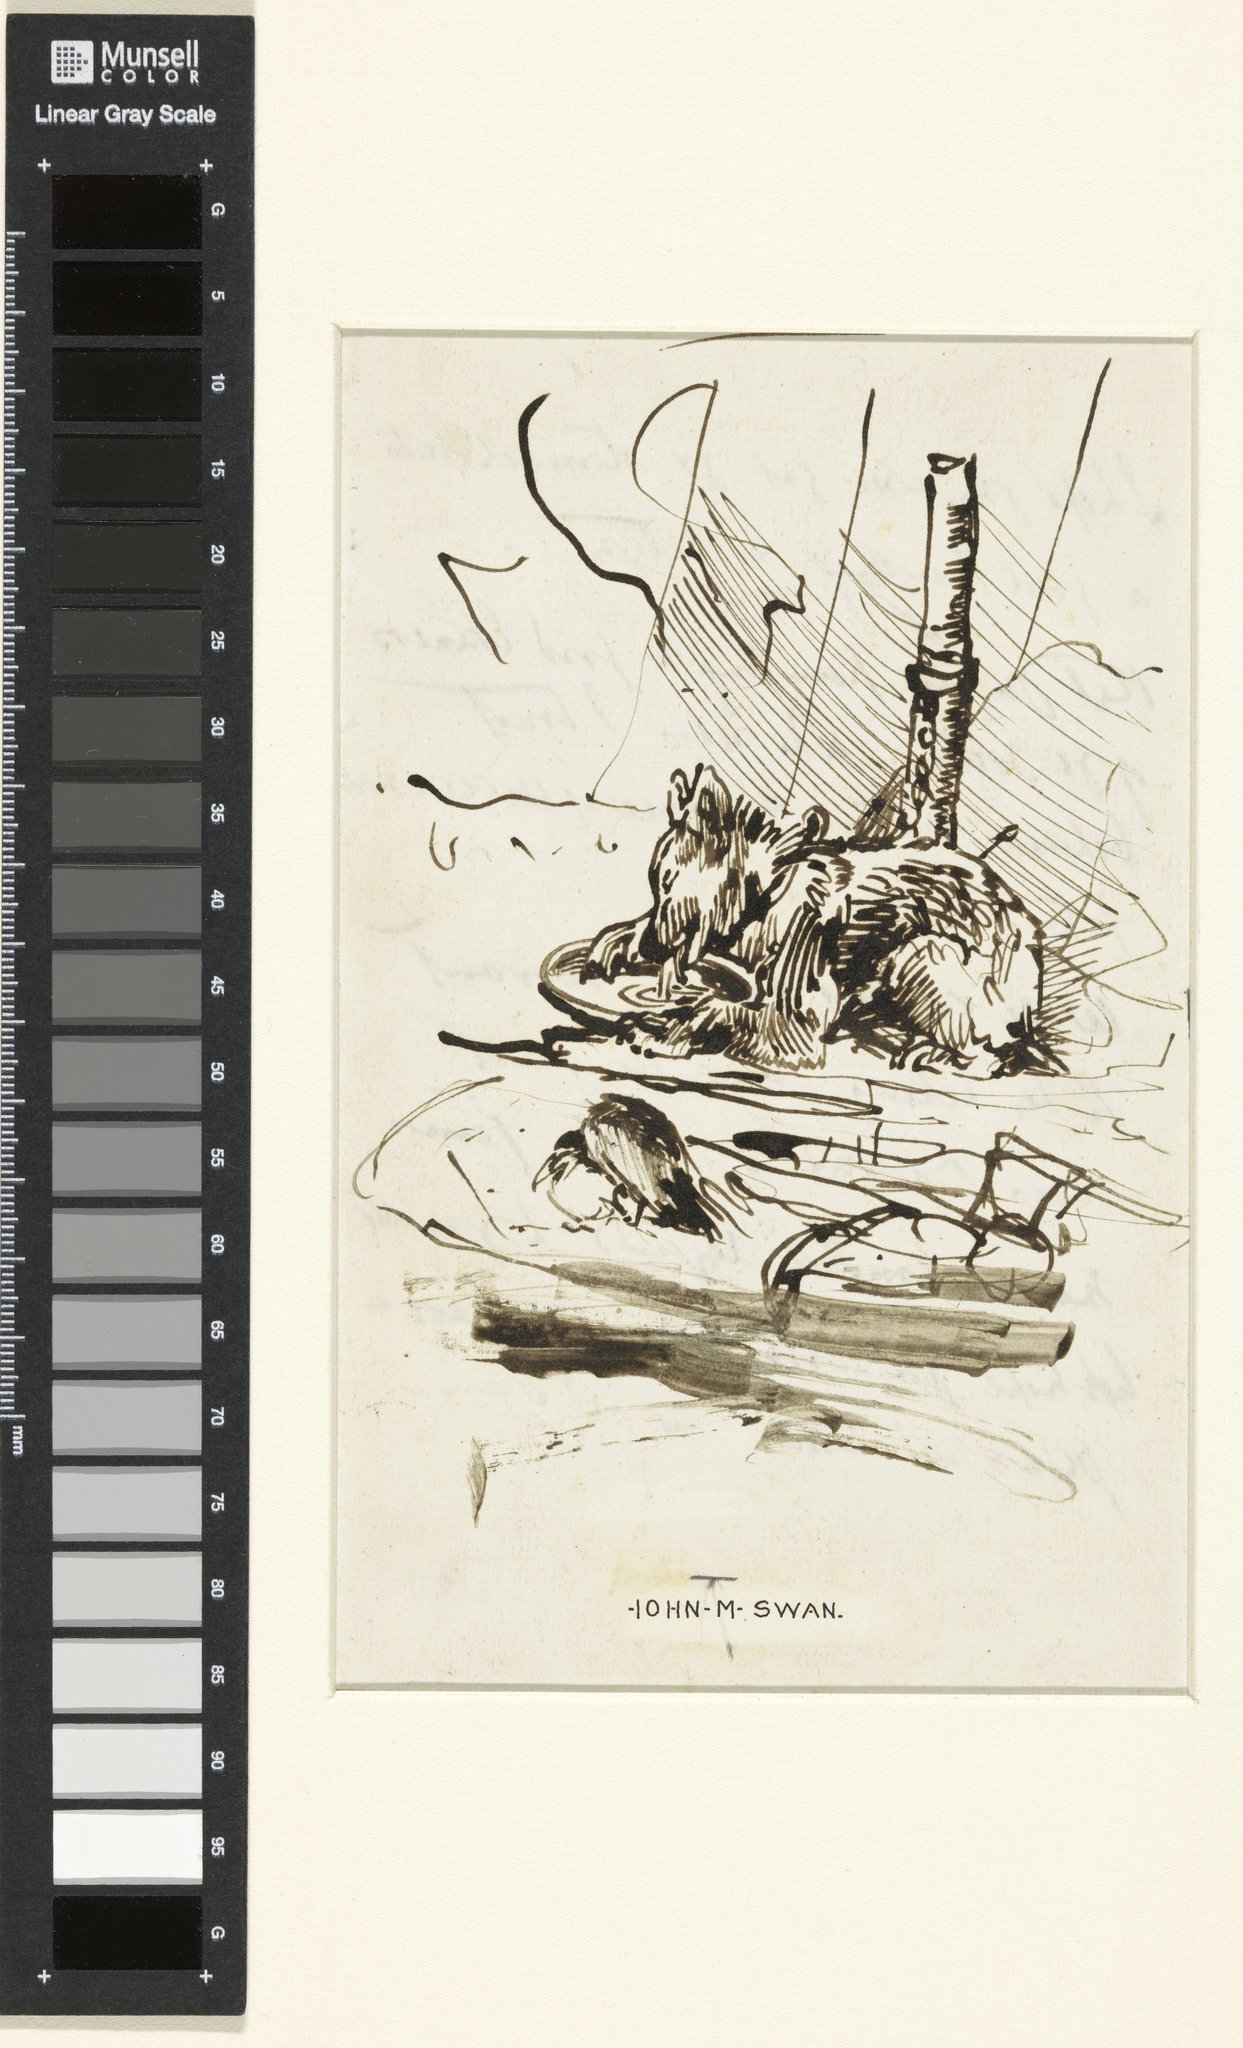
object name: drawing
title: Melk drinkend beertje en een tamme kraai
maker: john macallan swan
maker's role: draughtsman, painter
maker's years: 1847-1910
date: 1857-1910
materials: ink, paper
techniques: pen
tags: song-birds: crow